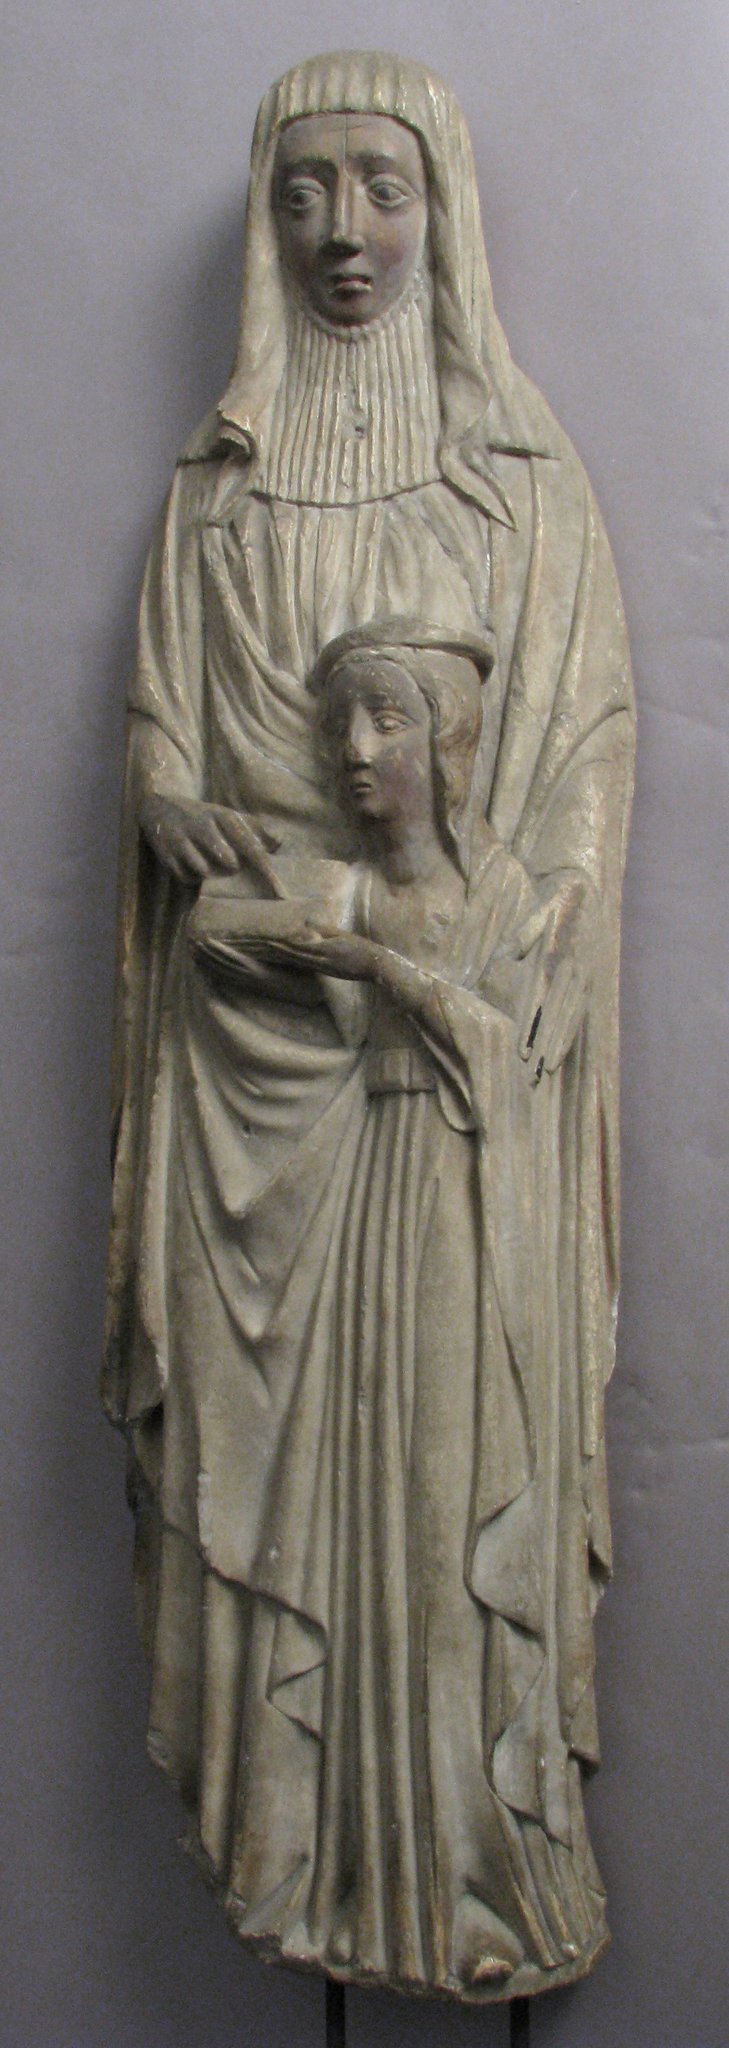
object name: relief statue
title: Education of the Virgin by Saint Anne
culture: spanish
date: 1401-1500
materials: alabaster, paint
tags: virgin mary